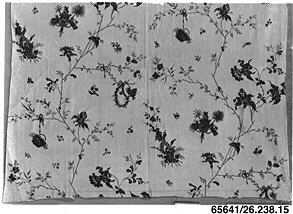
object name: floral print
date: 1785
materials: linen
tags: flowers